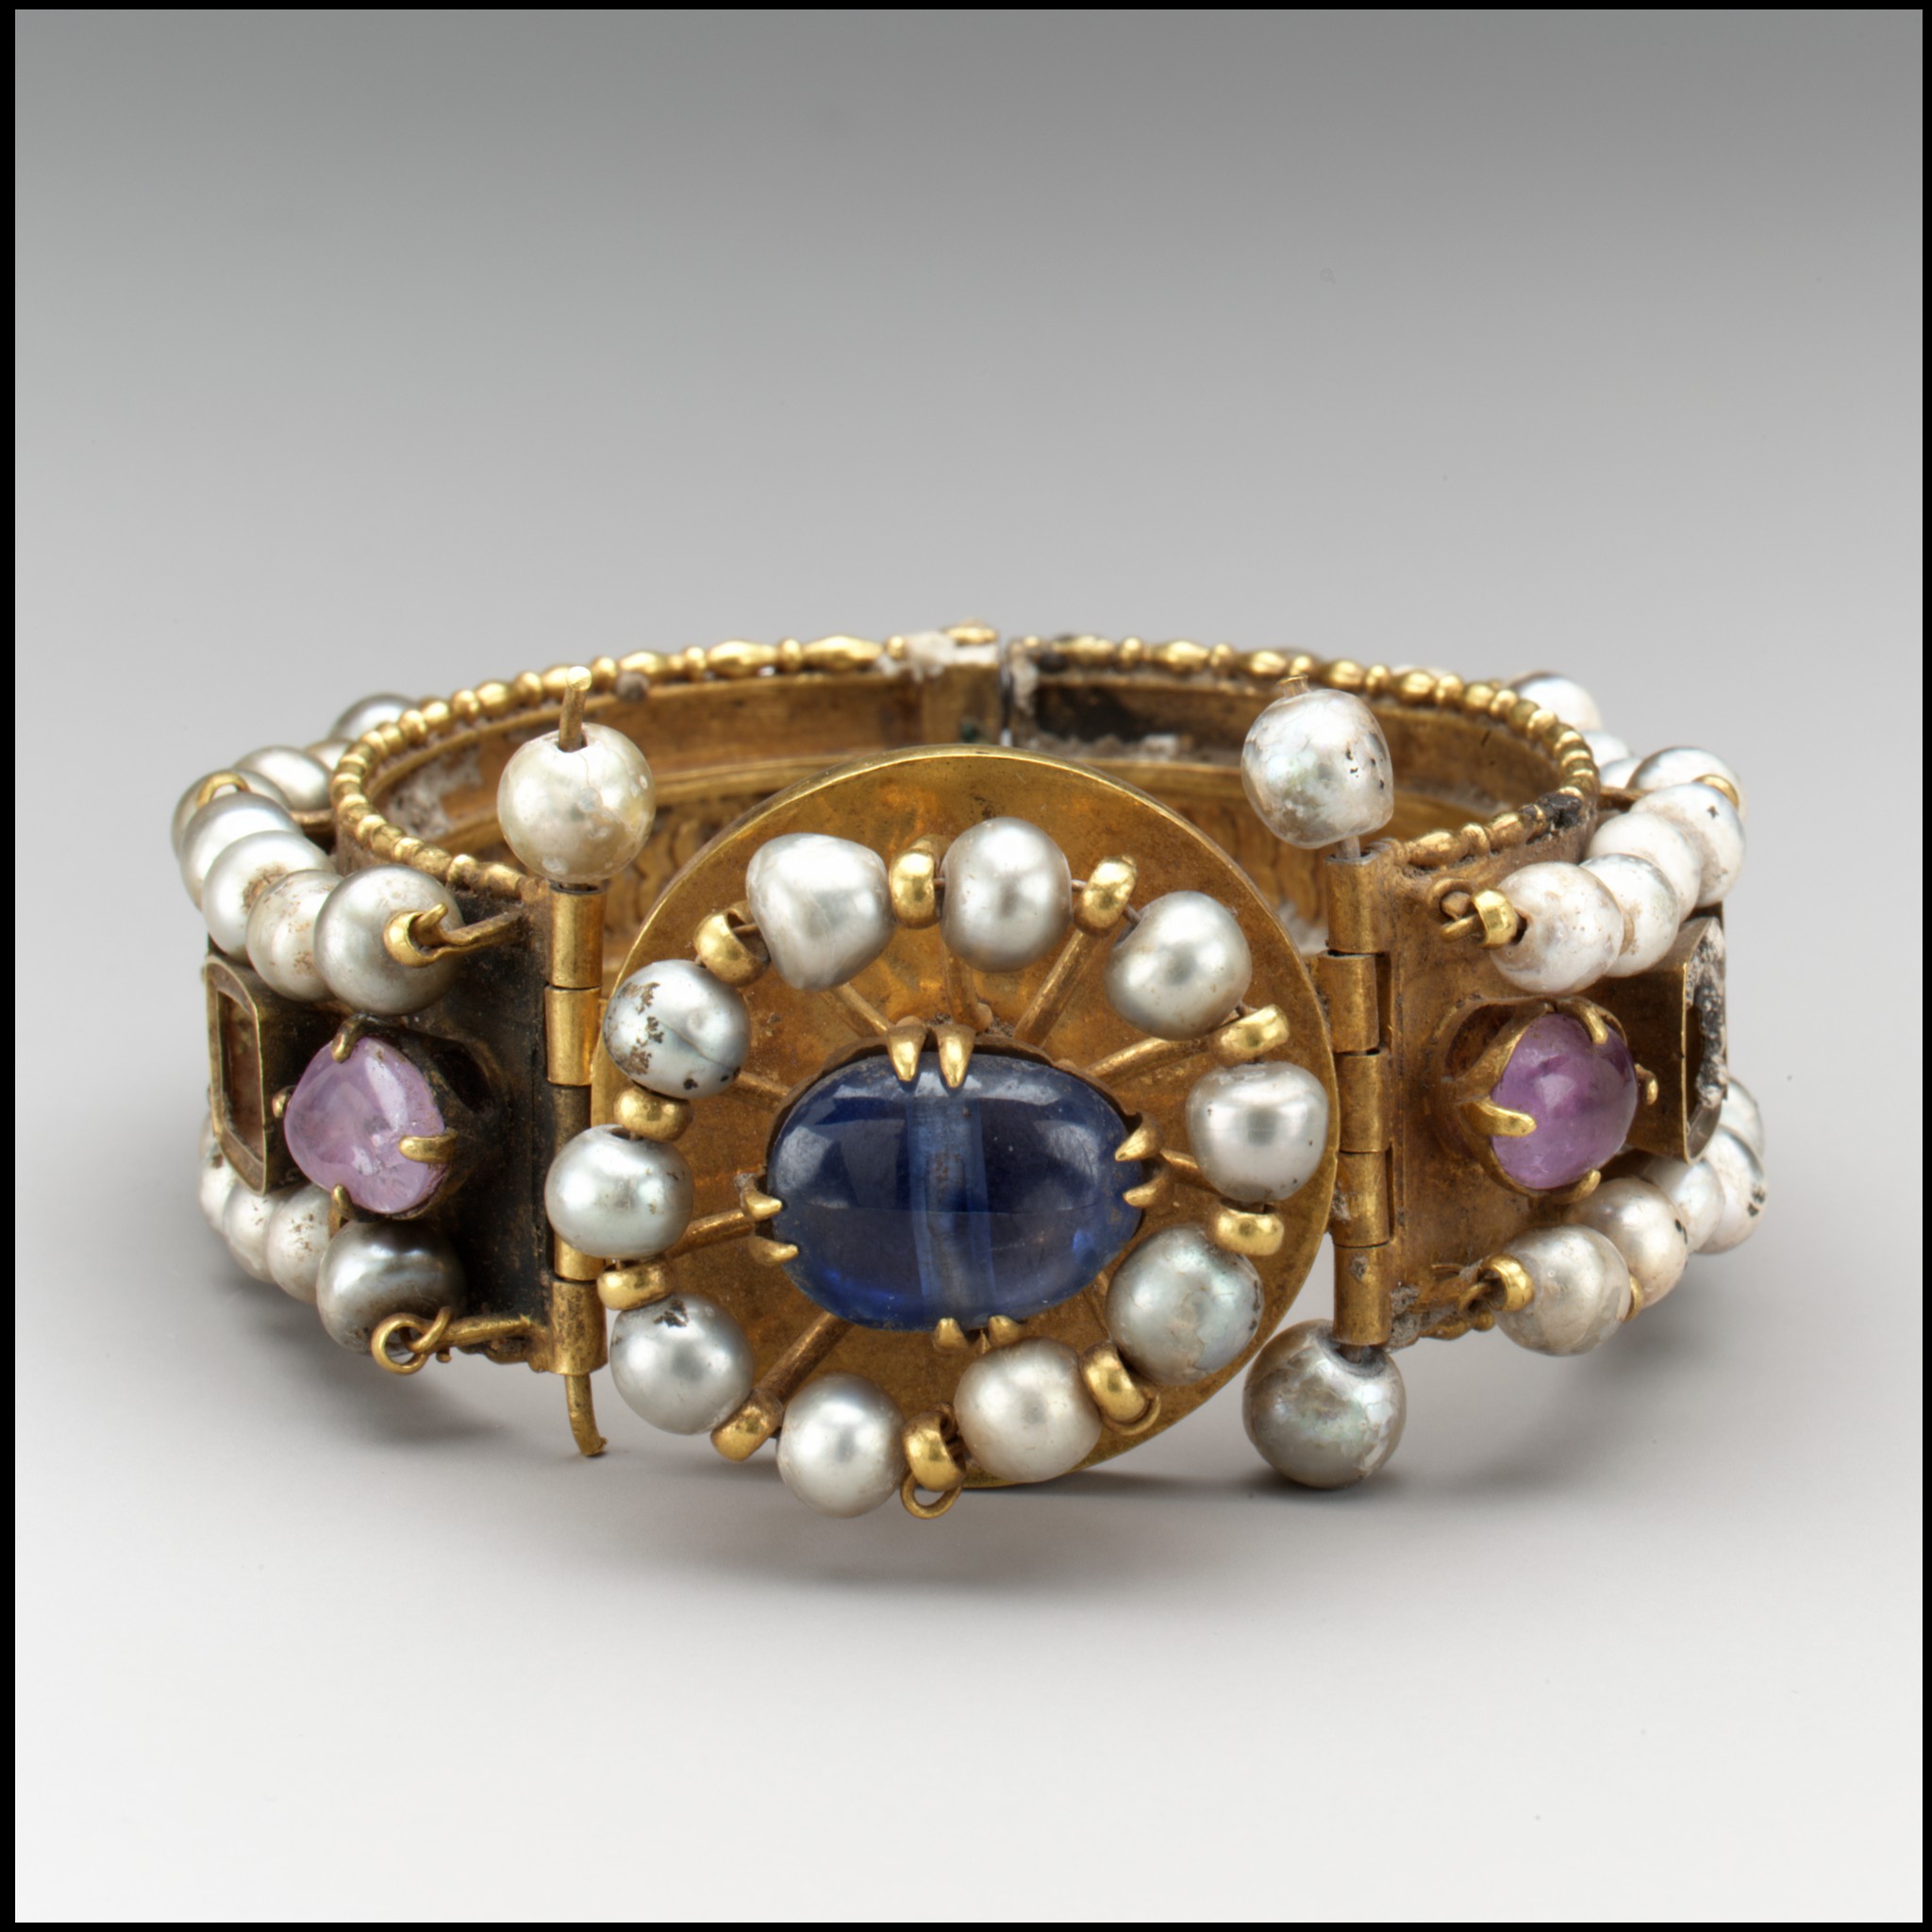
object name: bracelet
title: Jeweled Bracelet (one of pair)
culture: byzantine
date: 500-700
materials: gemstone, glass, gold, pearl, quartz, silver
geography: probably constantinople